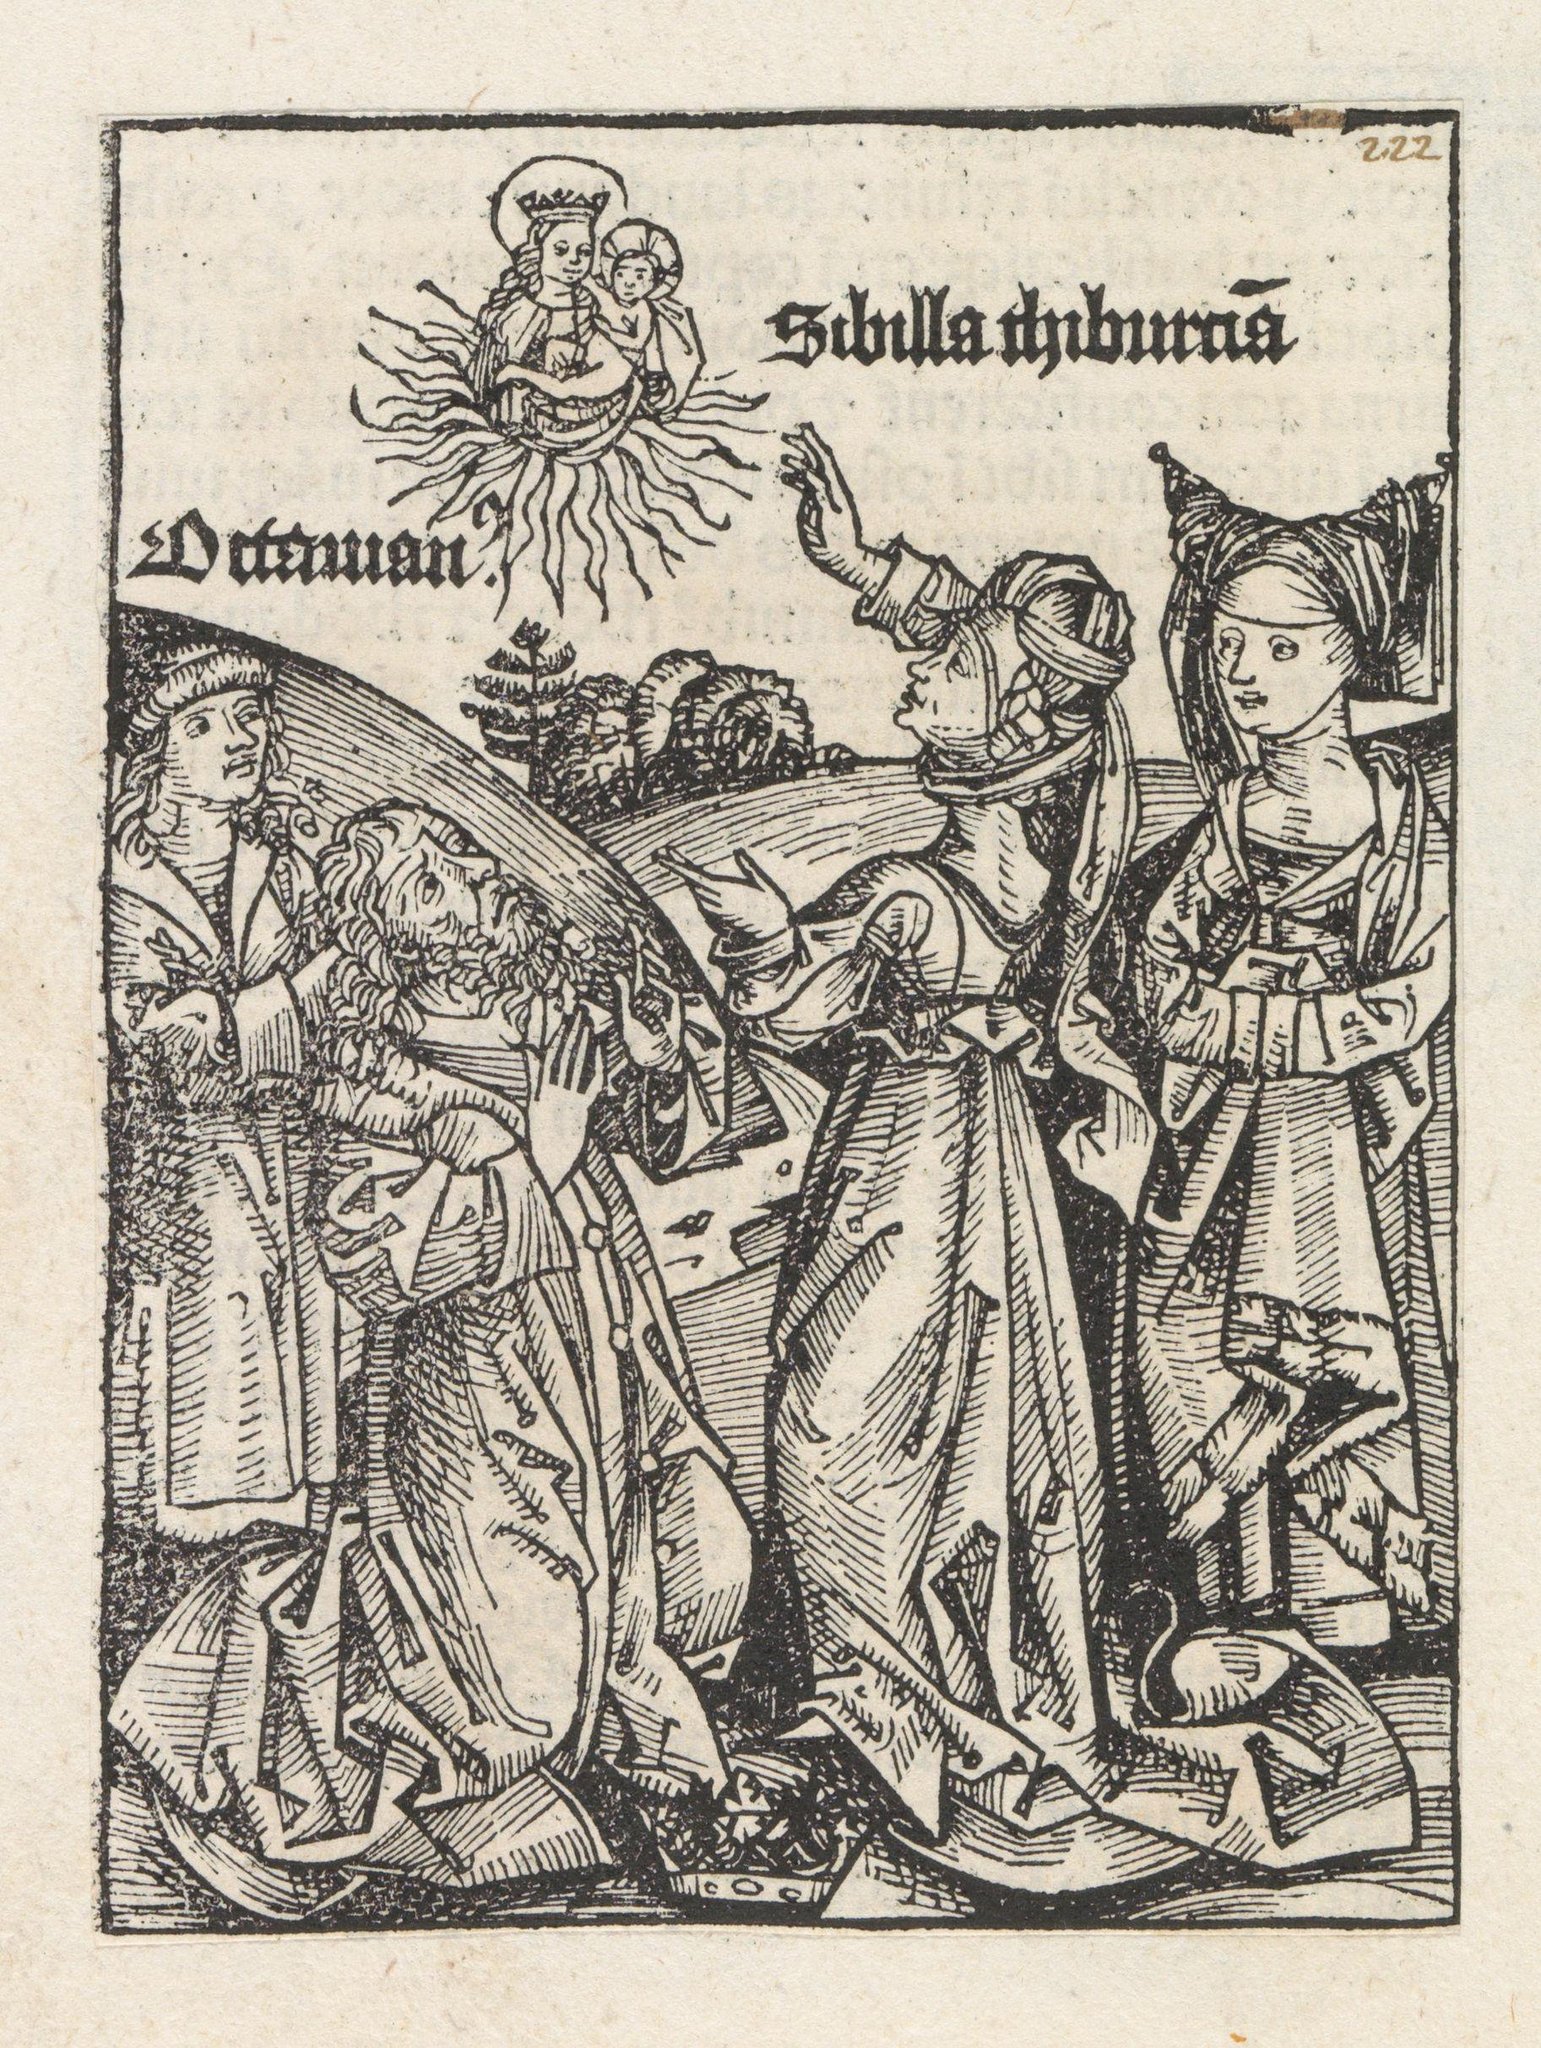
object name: print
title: Keizer Augustus en de Tiburtijnse sibylle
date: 1493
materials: paper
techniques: letterpress printing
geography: nuremberg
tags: the tiburtine sibyl and augustus: the sibyl reveals to the emperor a vision of the madonna in heaven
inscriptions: inscription: ‘222’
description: De Tiburtijnse sibille voorspelt aan keizer Augustus (Octavianus) de komst van Christus. De Romeinse keizer Augustus ziet Maria met het Kind in een visioen. Uit eerbied knielt hij op de grond en legt zijn kroon naast zich neer. De prent maakt deel uit van een album.